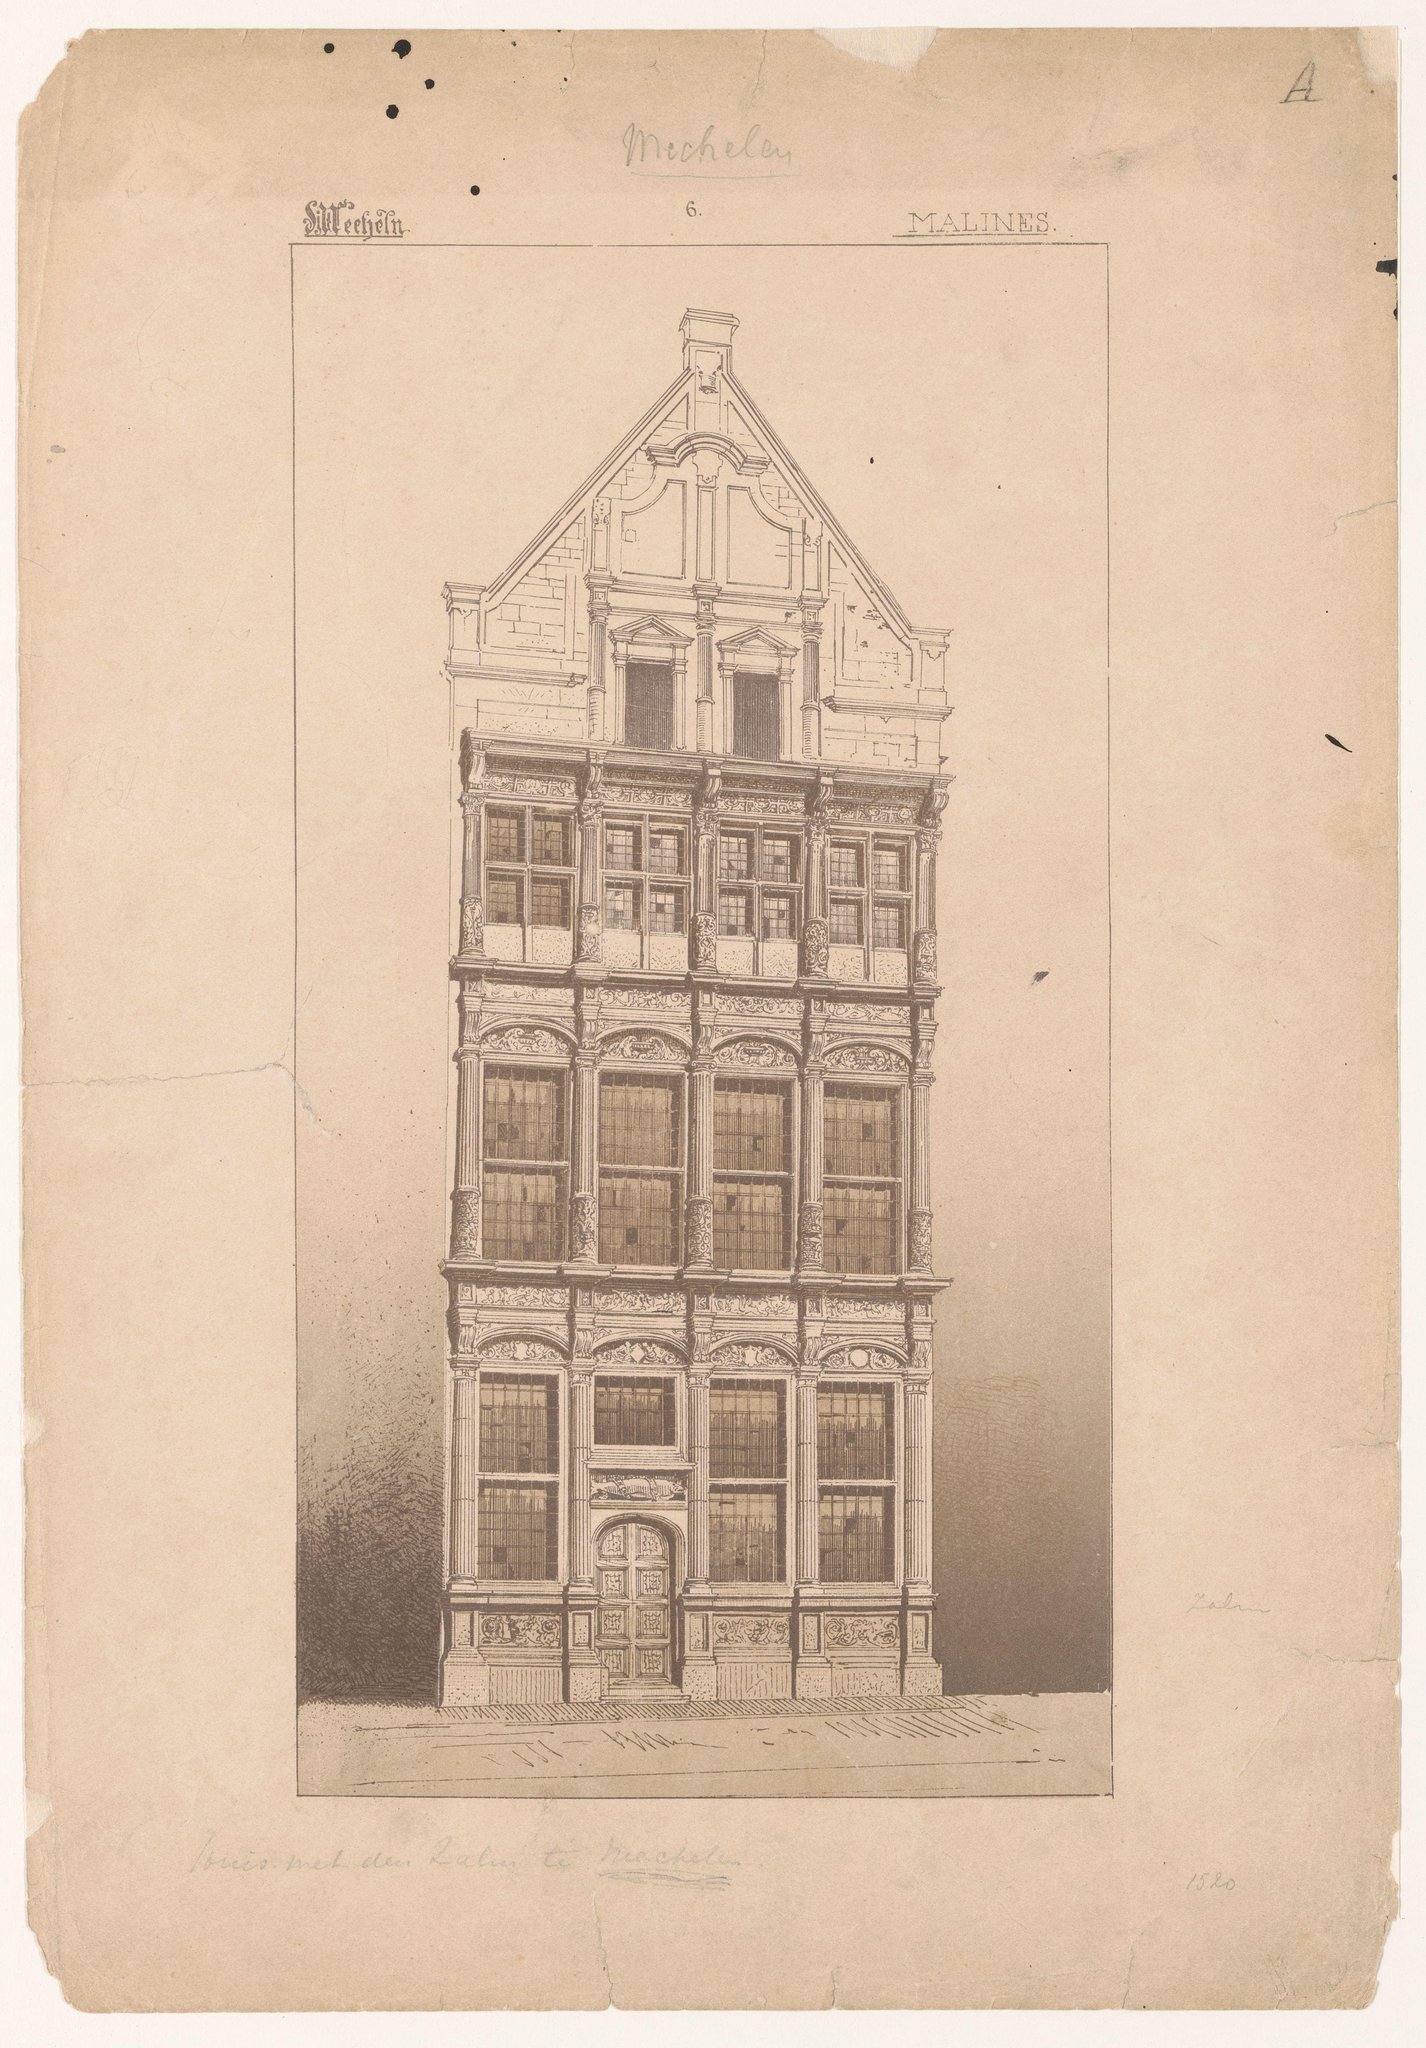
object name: print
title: Gevel van Gildehuis In den Grooten Zalm in Mechelen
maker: Anonymous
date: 1800-1899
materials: paper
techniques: tone lithography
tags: guildhall, mechelen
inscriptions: collector's mark: Lugt 3937